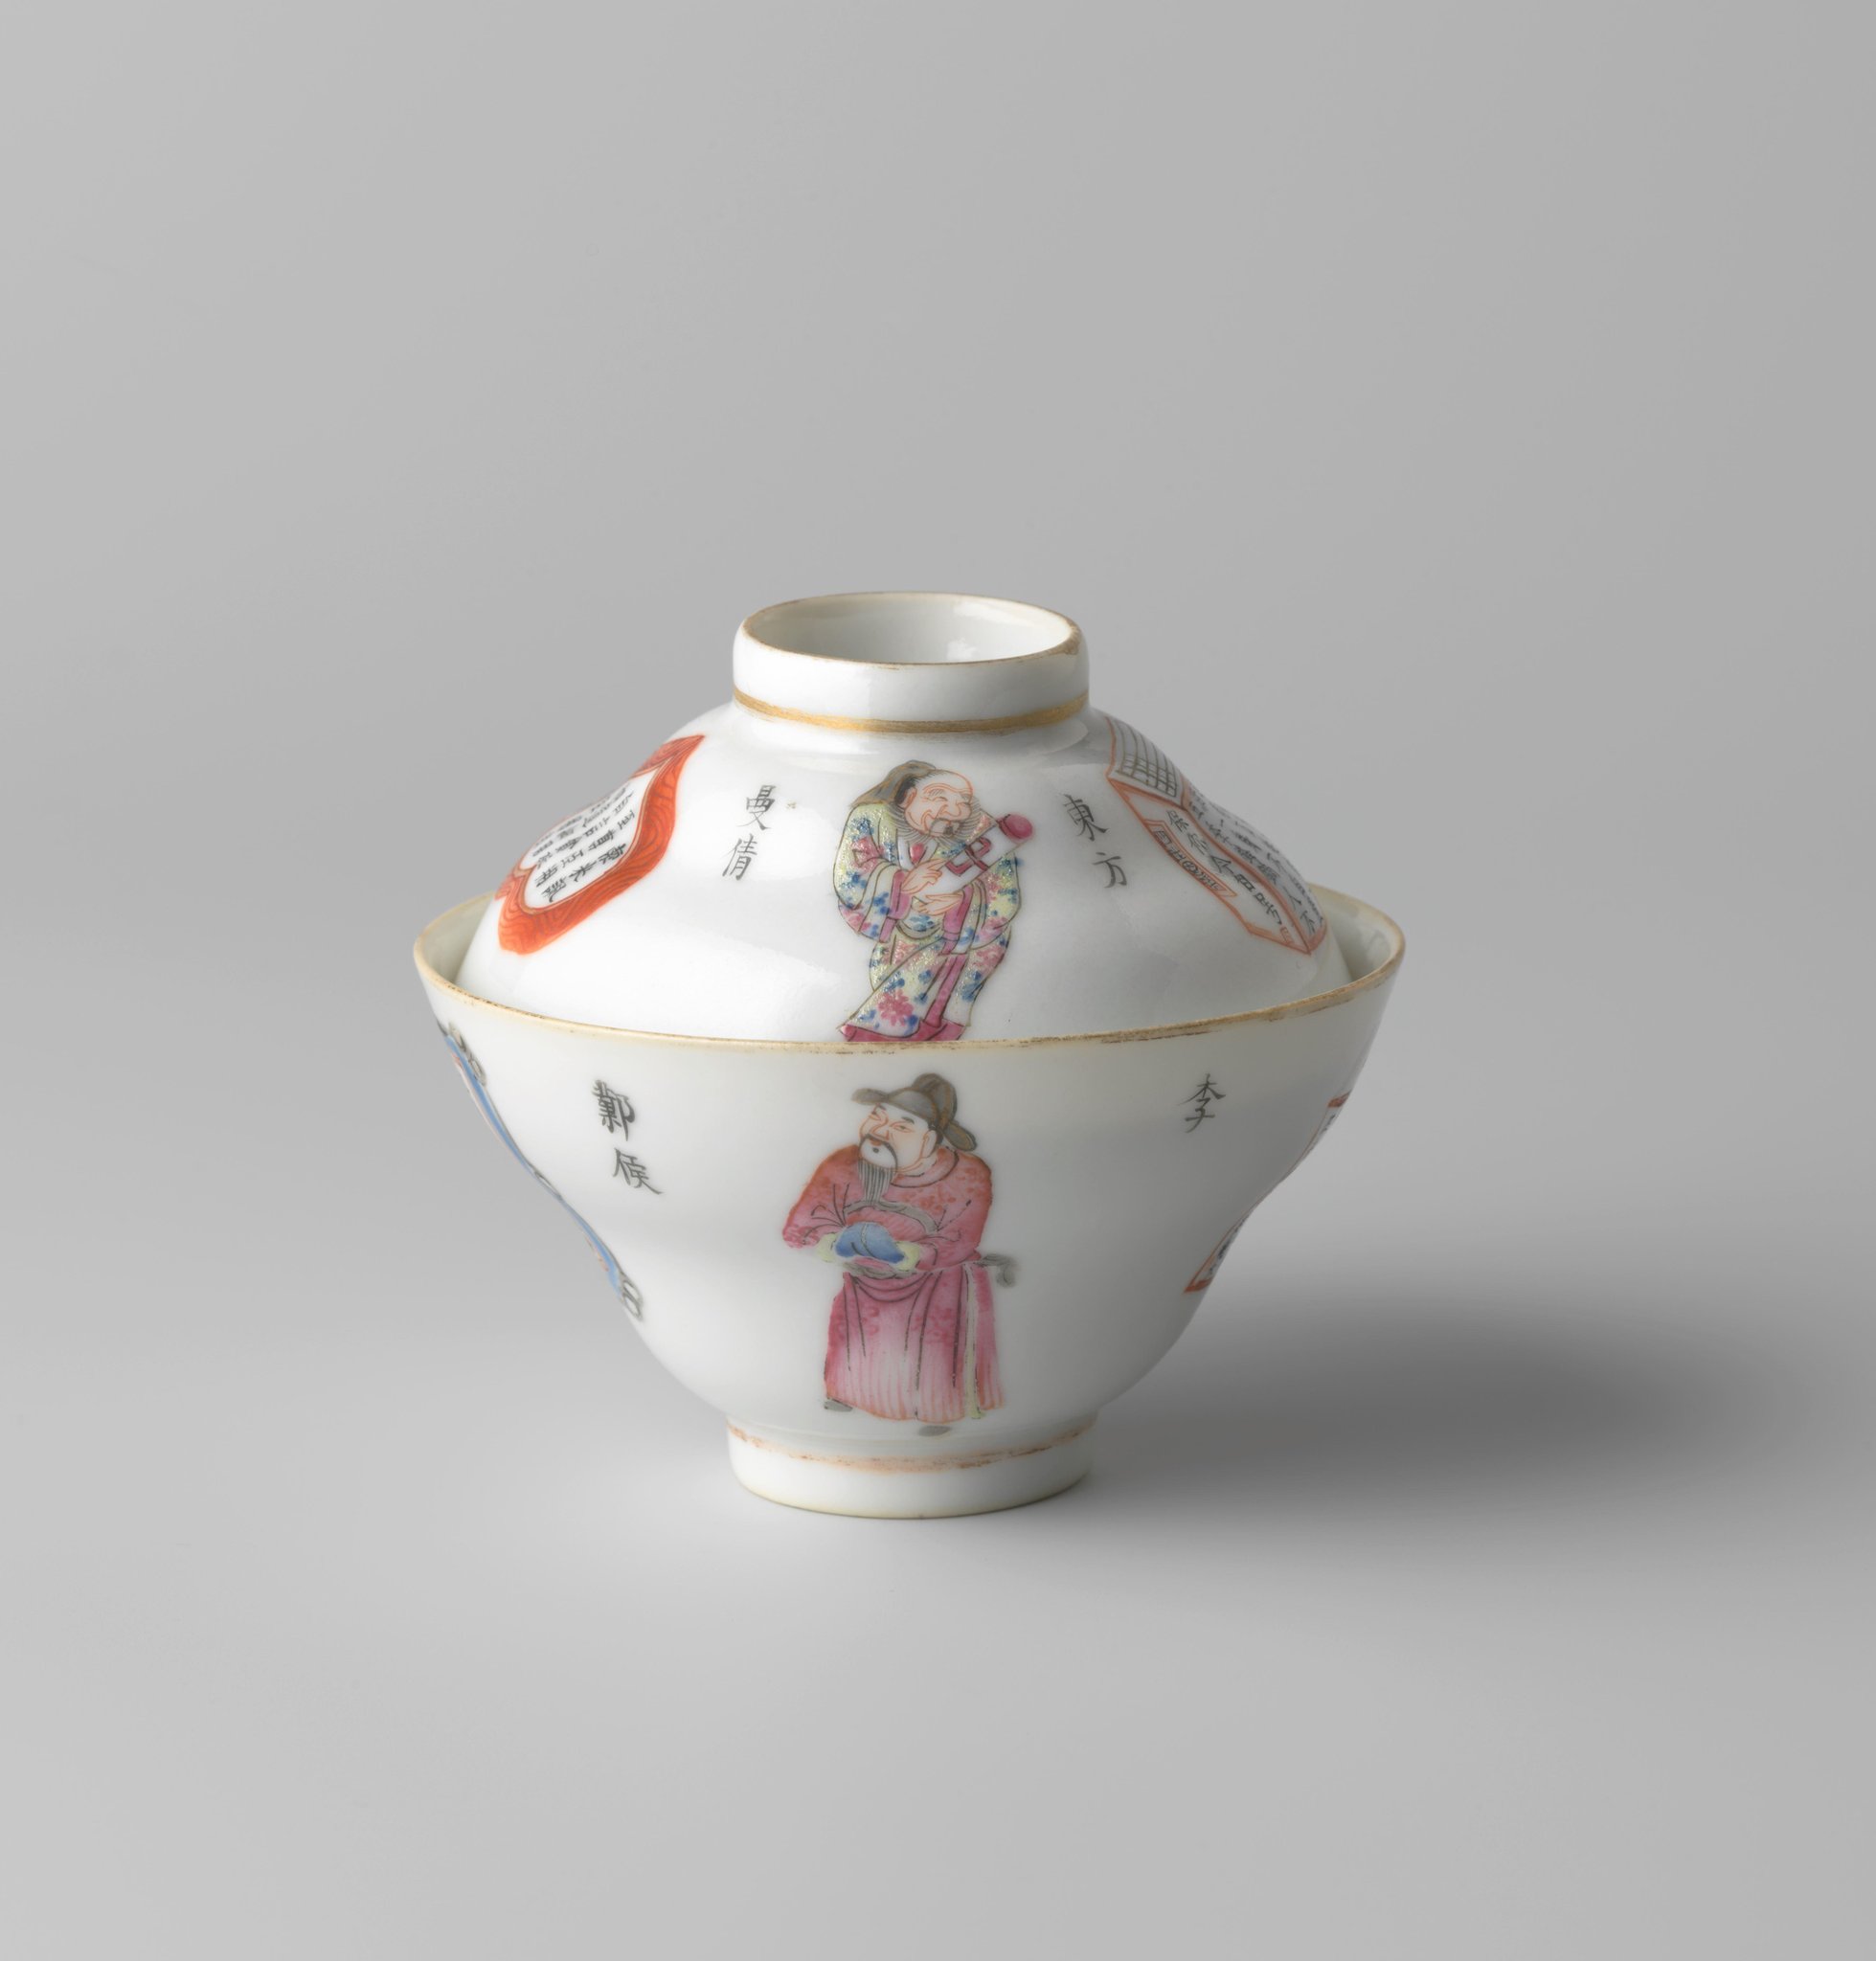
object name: kop en schotel, kop en schotel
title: Covered cup with figures, a go-bord and inscriptions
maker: Anonymous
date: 1800-1899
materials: glaze, gold, paint, porcelain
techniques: firing, gilding, turning, vitrification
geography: china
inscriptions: mark: ‘大 清 咸 豐 年 製’, mark: ‘大 清 道 光 年 製’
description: Deksel van kop van porselein met een getrapte wand, beschilderd op het glazuur in blauw, rood, roze, groen, geel, zwart en goud. De deksel met dezelfde soort decoratie als de schotel, met twee andere personen en twee cartouches met opschriften. De deksel gemerkt met het zegelmerk van keizer Daoguang (?). Famille rose.